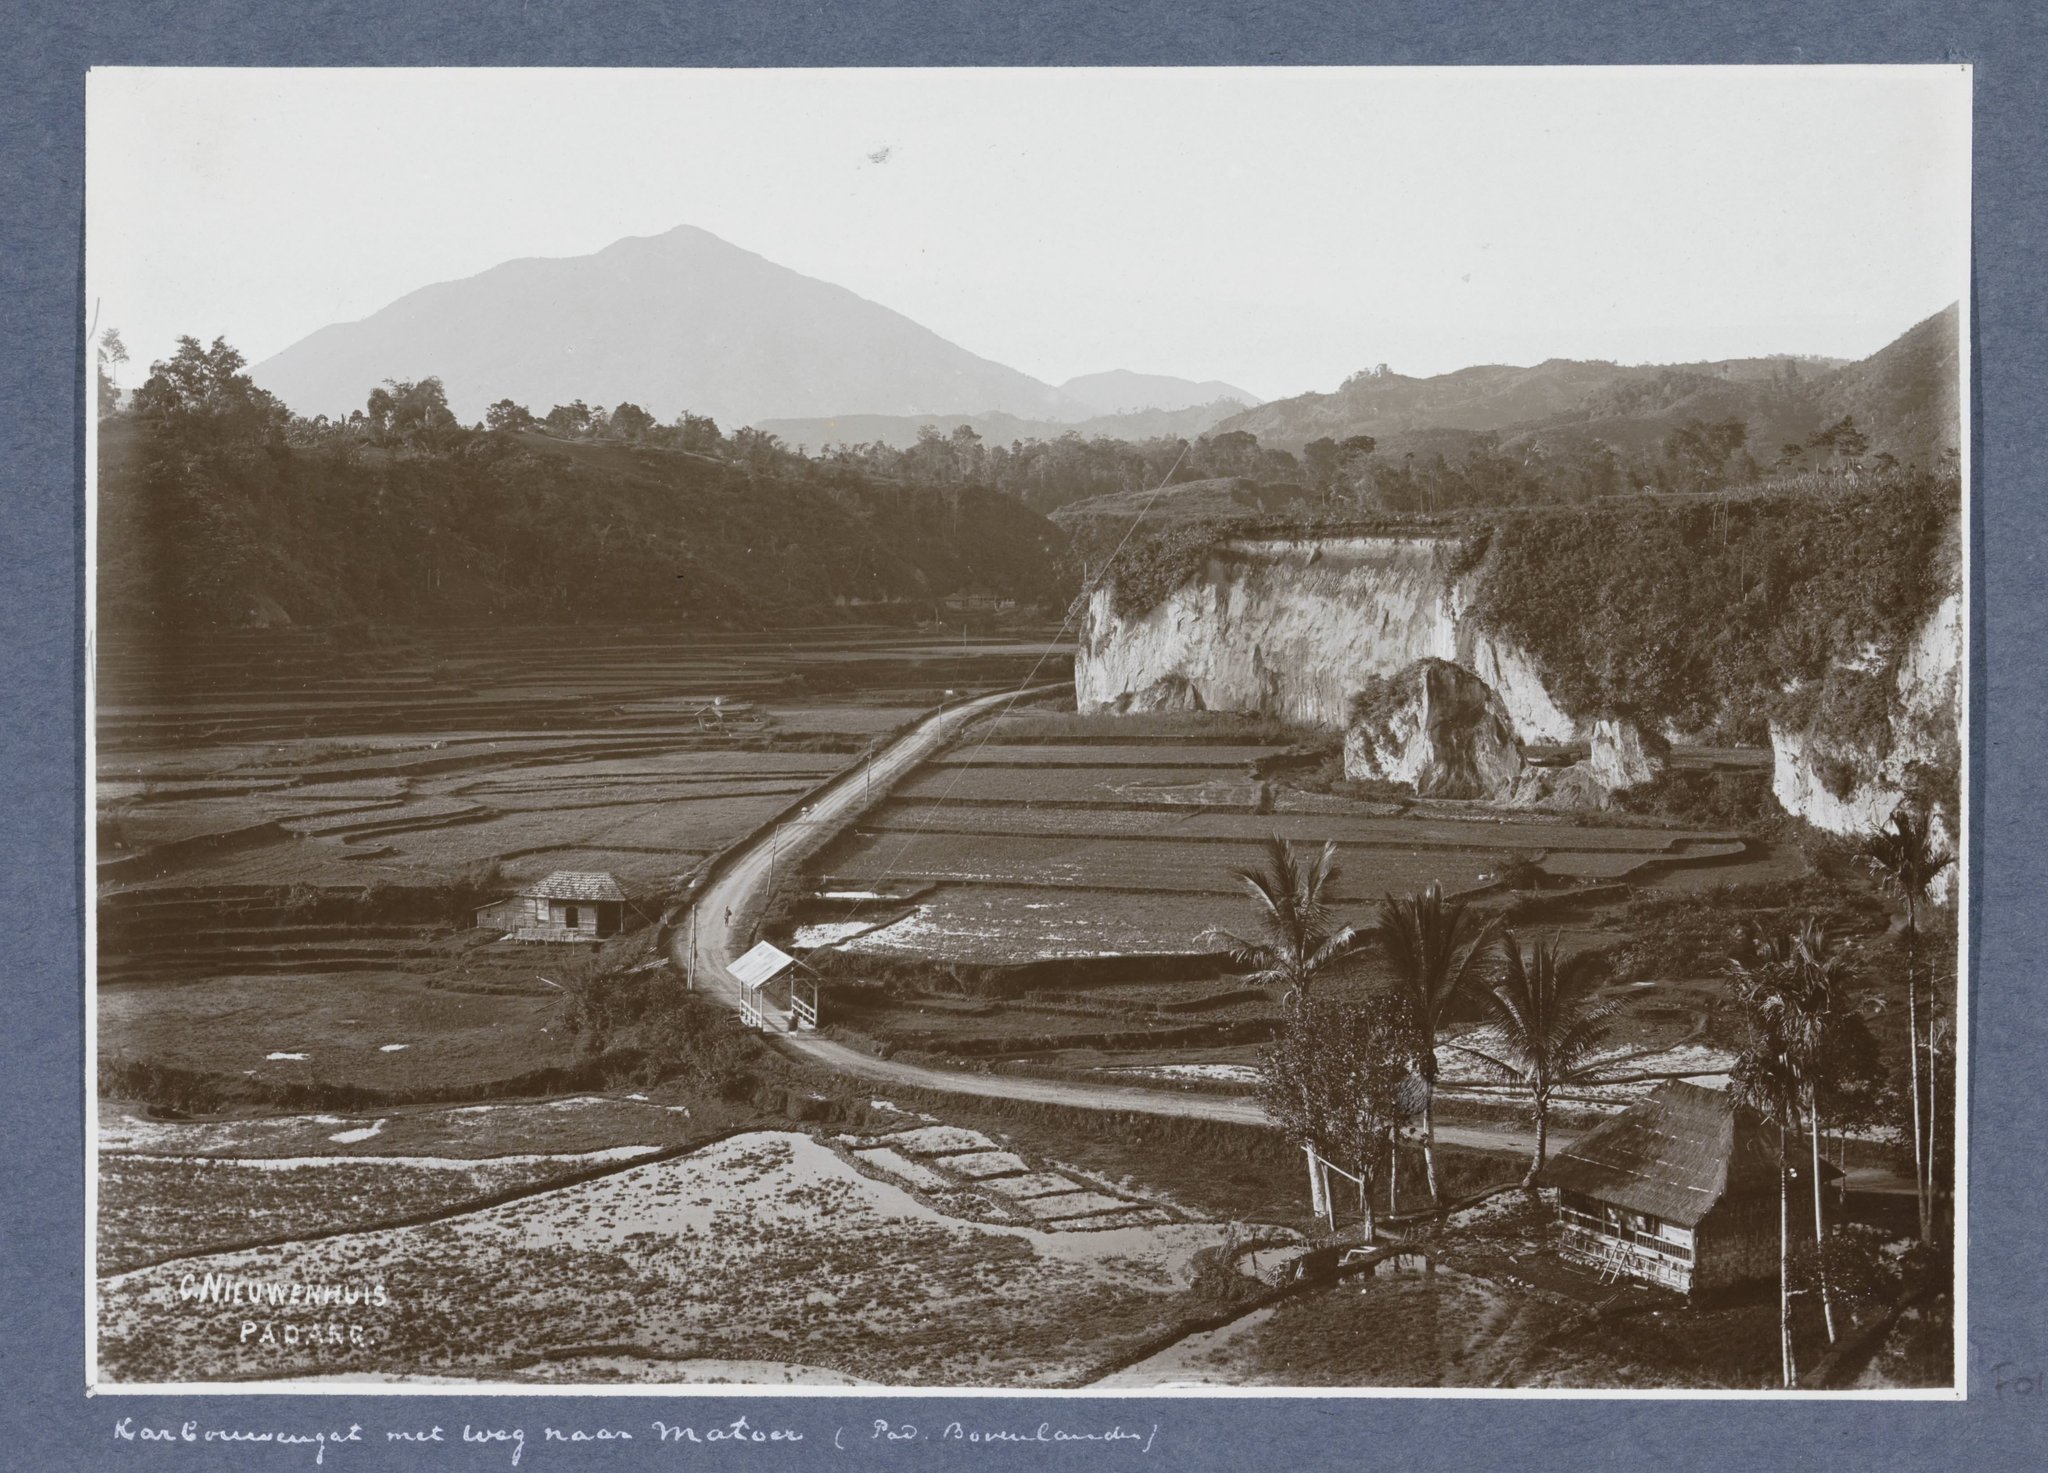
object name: album leaf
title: Gezicht op Karbouwengat en de weg naar Matoer op Sumatra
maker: christiaan benjamin nieuwenhuis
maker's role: publisher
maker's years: 1863-1922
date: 1900-1920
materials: paper, photographic support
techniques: gelatin silver print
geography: sumatra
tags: ravine, chasm, abyss, canyon, public road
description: Onderdeel van reisalbum met foto's van bedrijvigheid en bezienswaardigheden op Sumatra en Java en van de reis naar en van Nederlands-Indië.